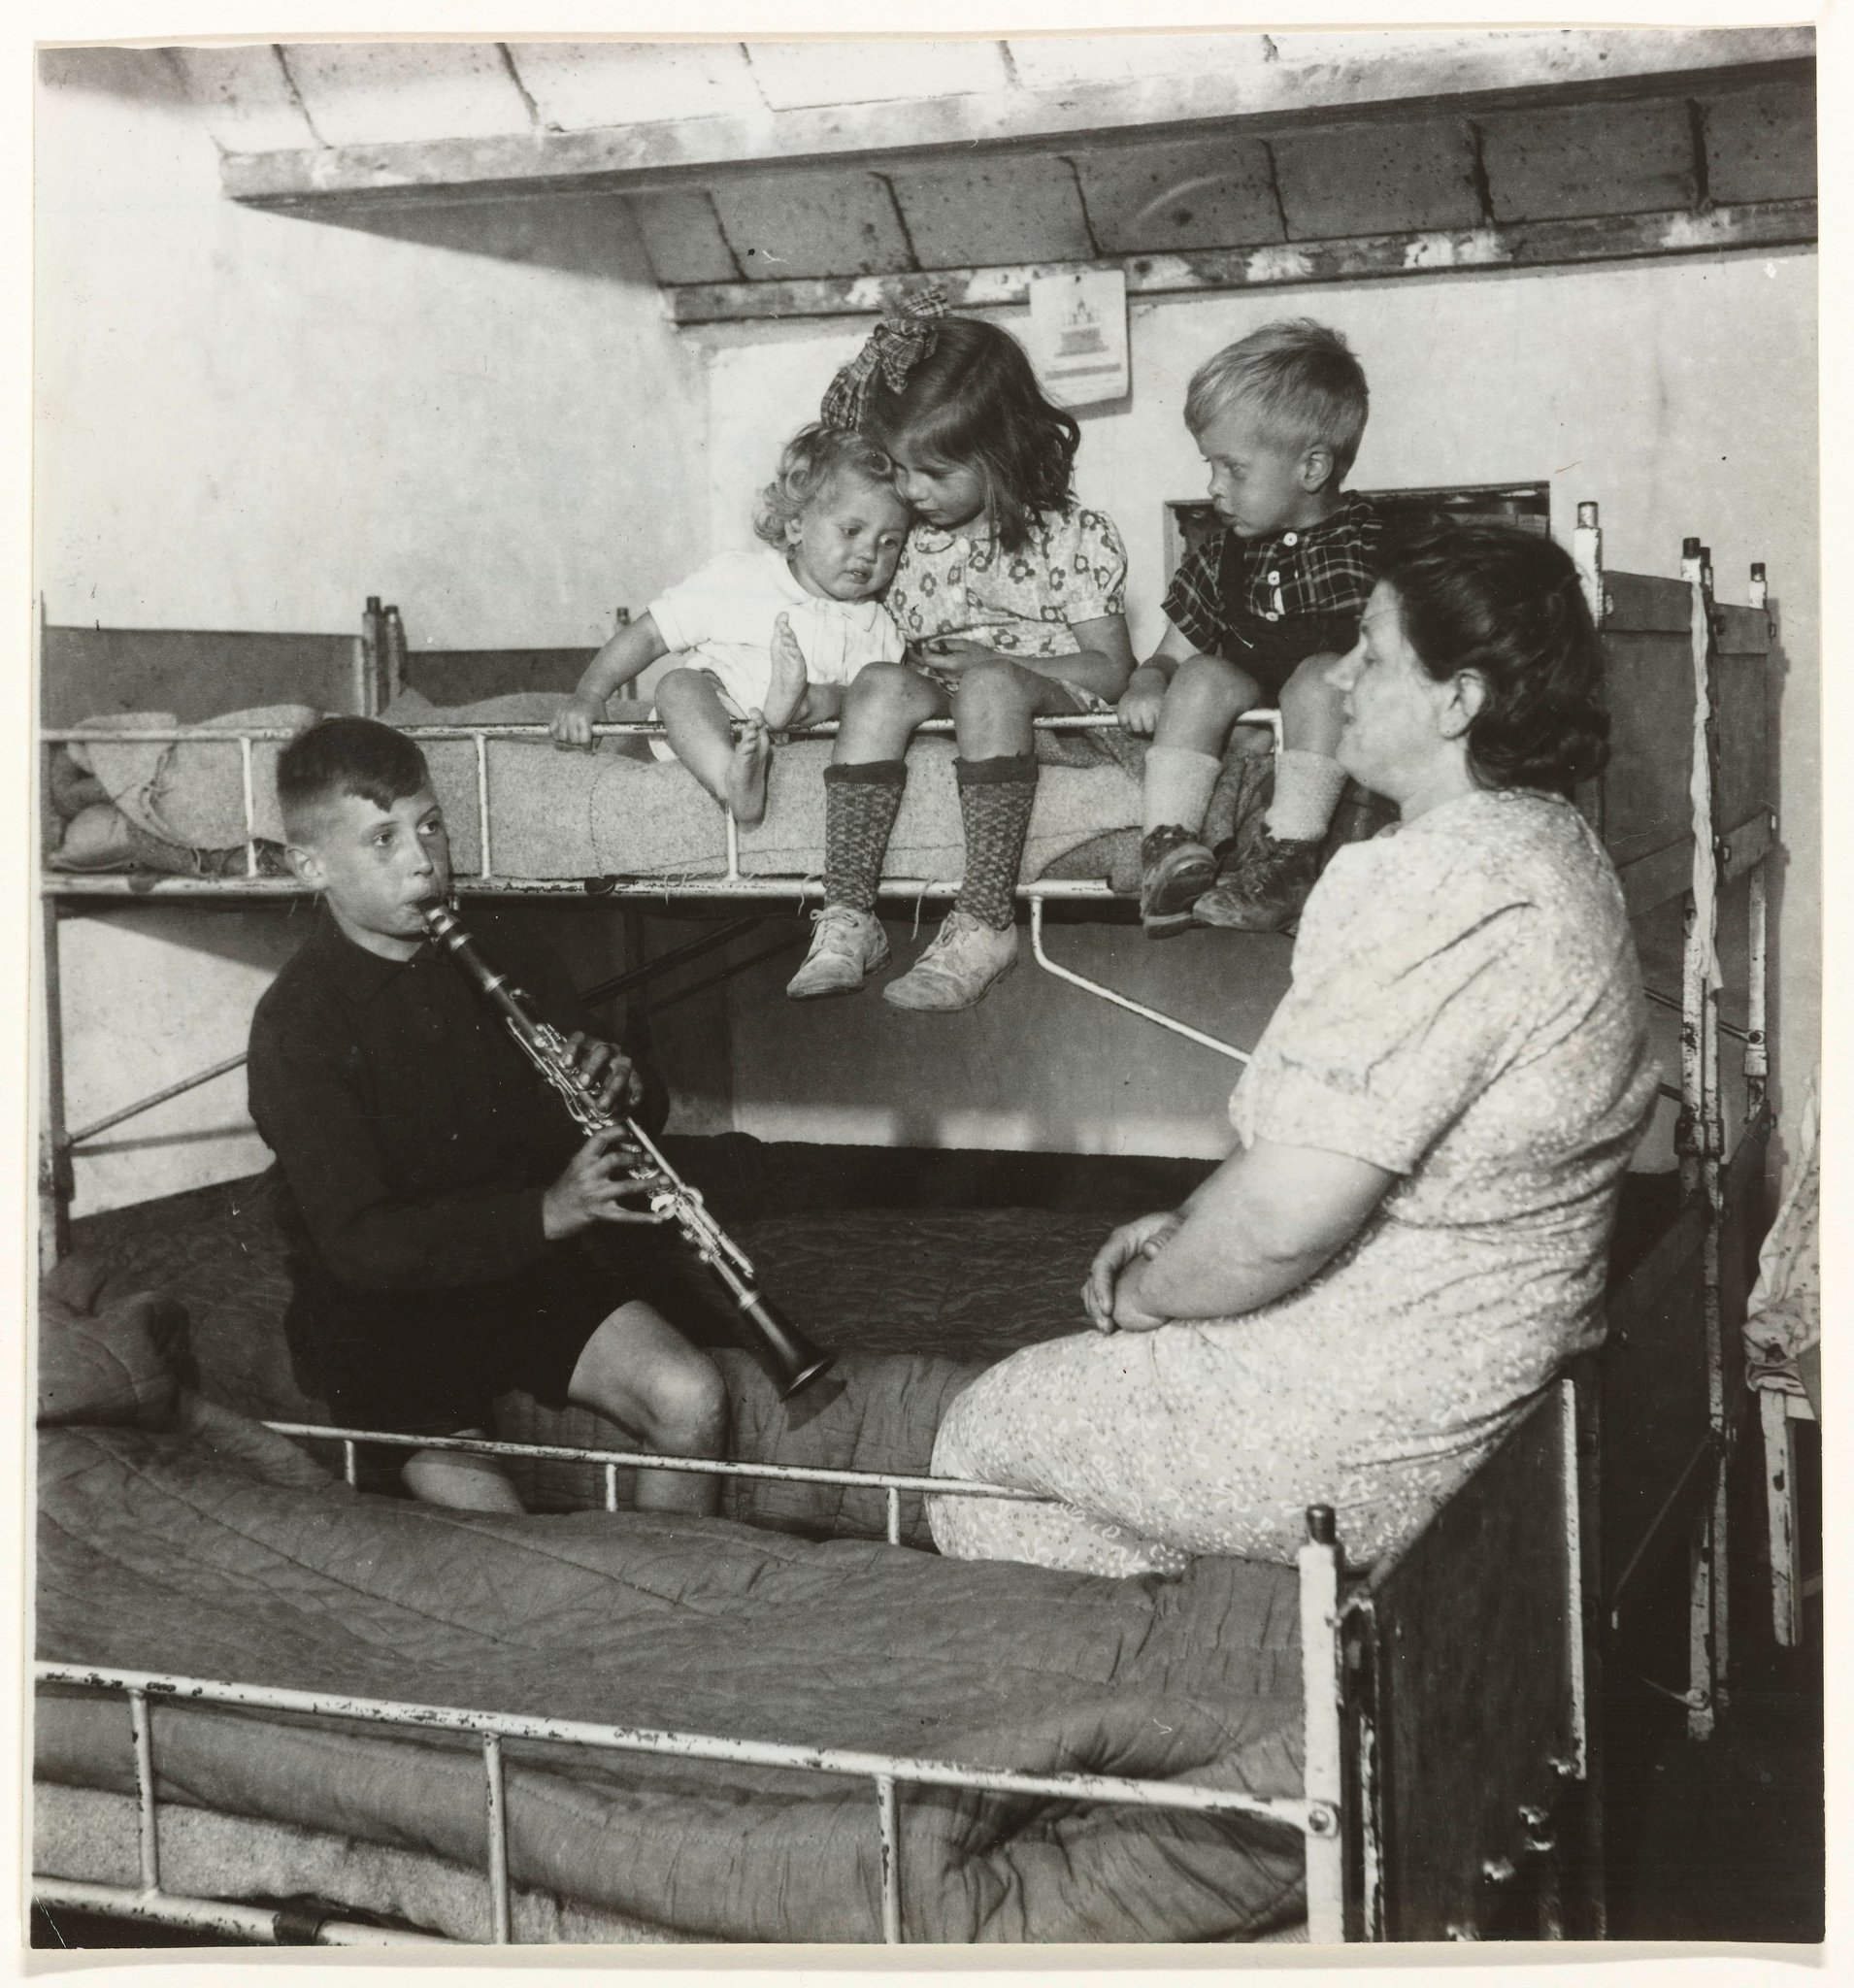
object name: documentary photograph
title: Vier kinderen en hun moeder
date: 1945-1947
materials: photographic support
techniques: photography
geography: netherlands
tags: netherlands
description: Op een stapelbed van metaal zitten drie jonge kinderen, wat lager op een gewoon bed een jongetje met een klarinet, zijn moeder zit tegenover hem.